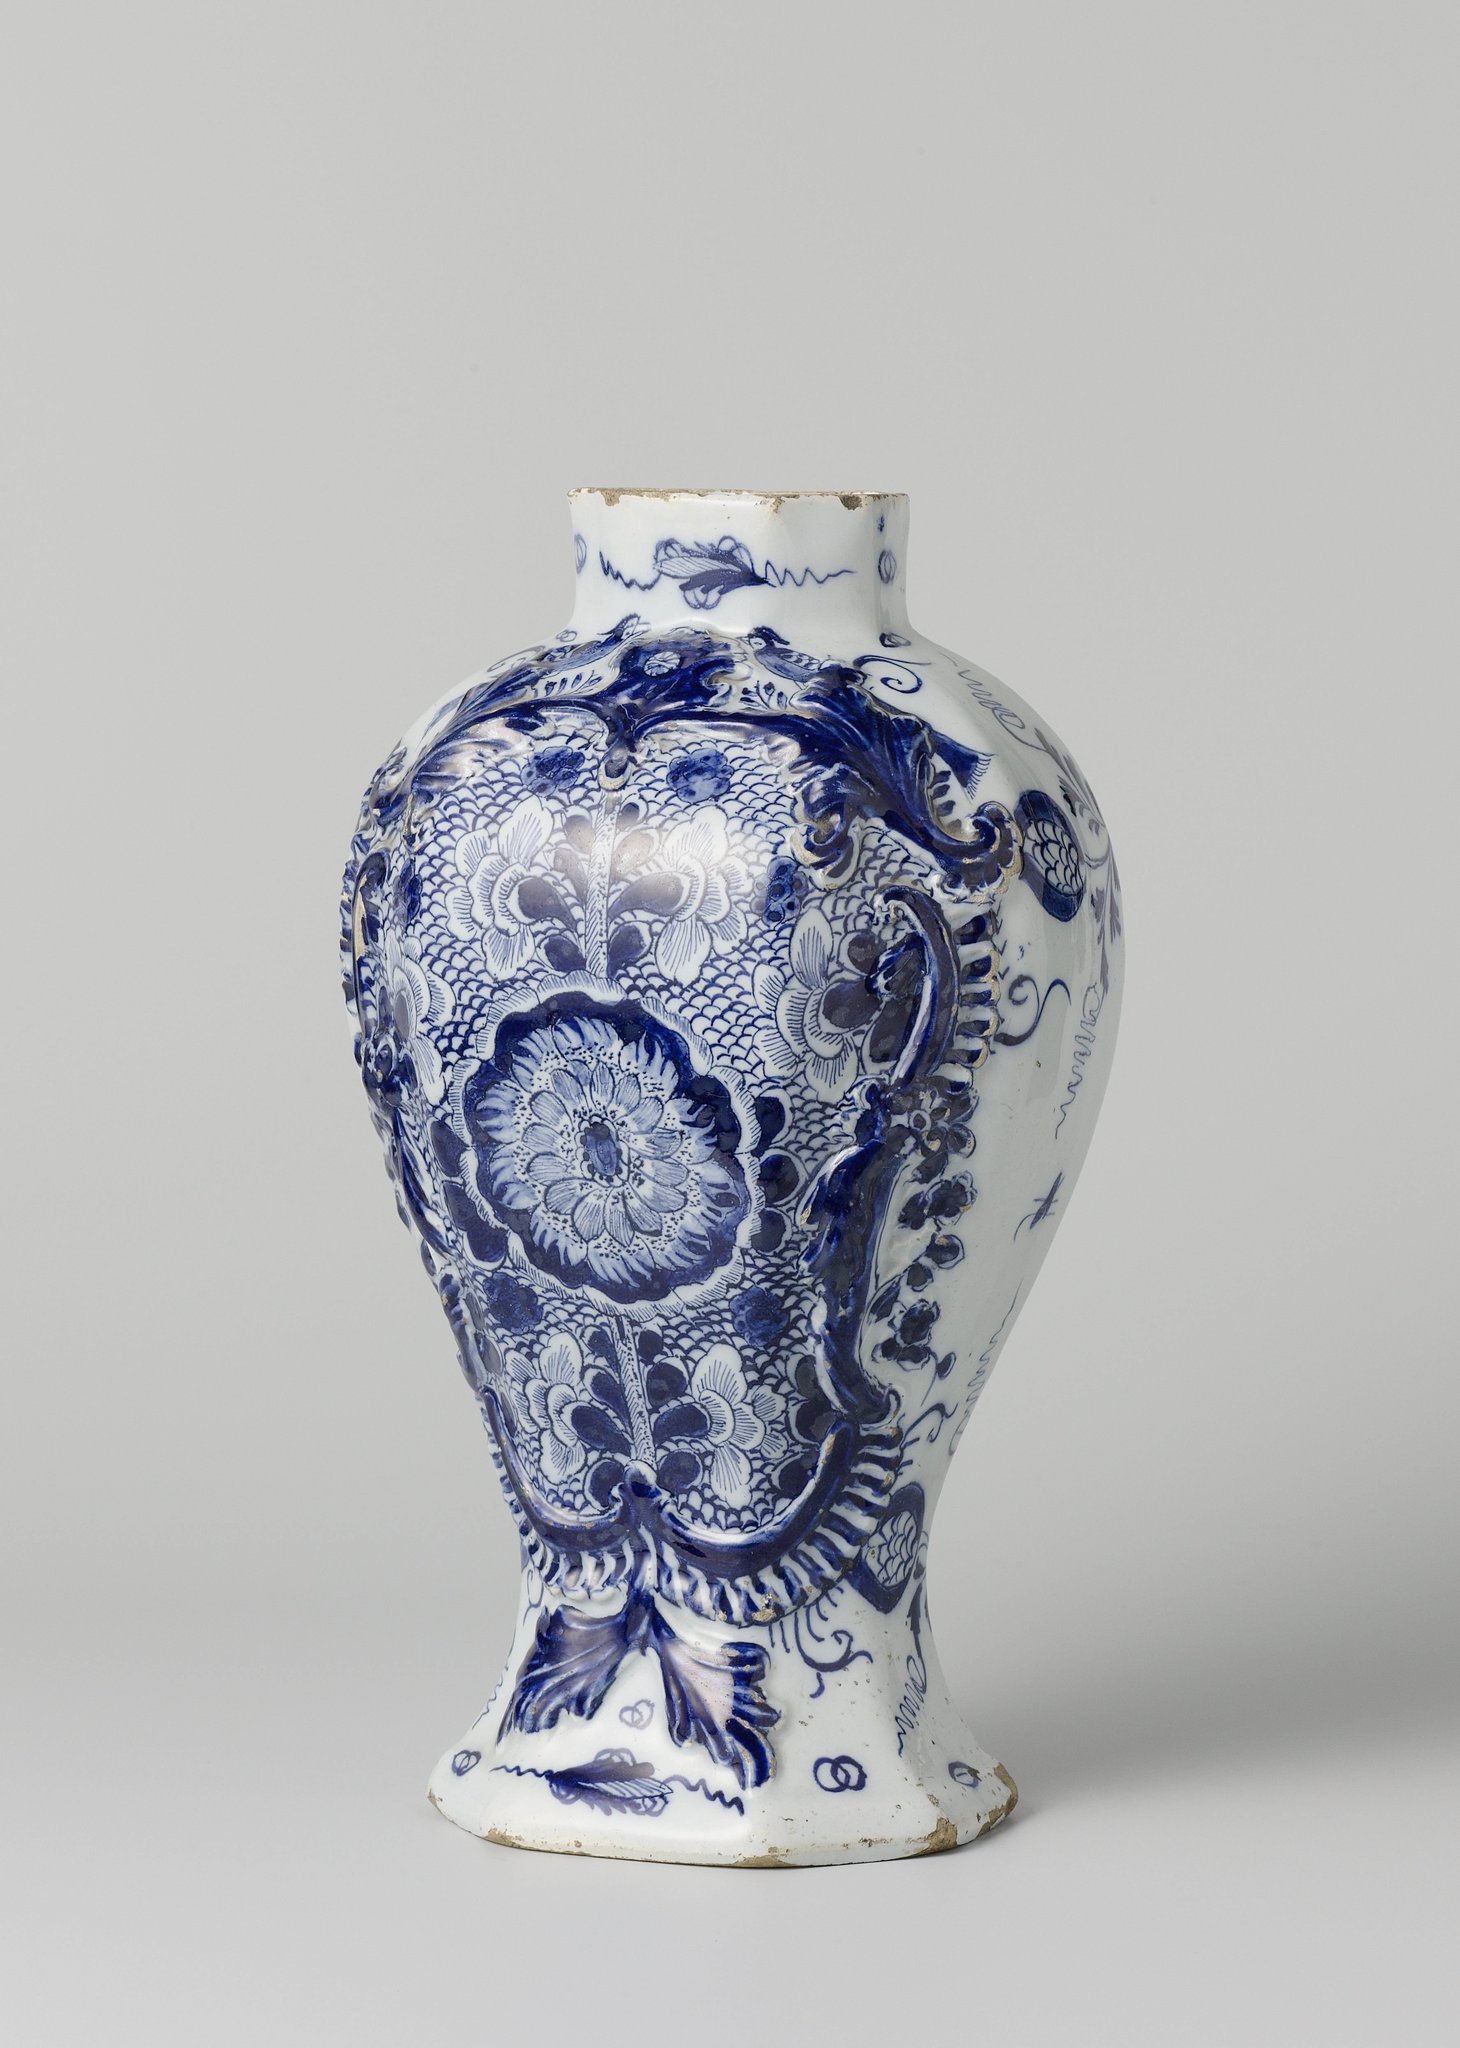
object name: covered jar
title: Pot van blauw beschilderde faience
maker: Anonymous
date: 1750-1825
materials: earthenware, glaze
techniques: painted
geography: netherlands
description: Pot (zonder deksel), blauw-wit beschilderd met bloemen, omkaderd met voluten en bladwerk in relief.